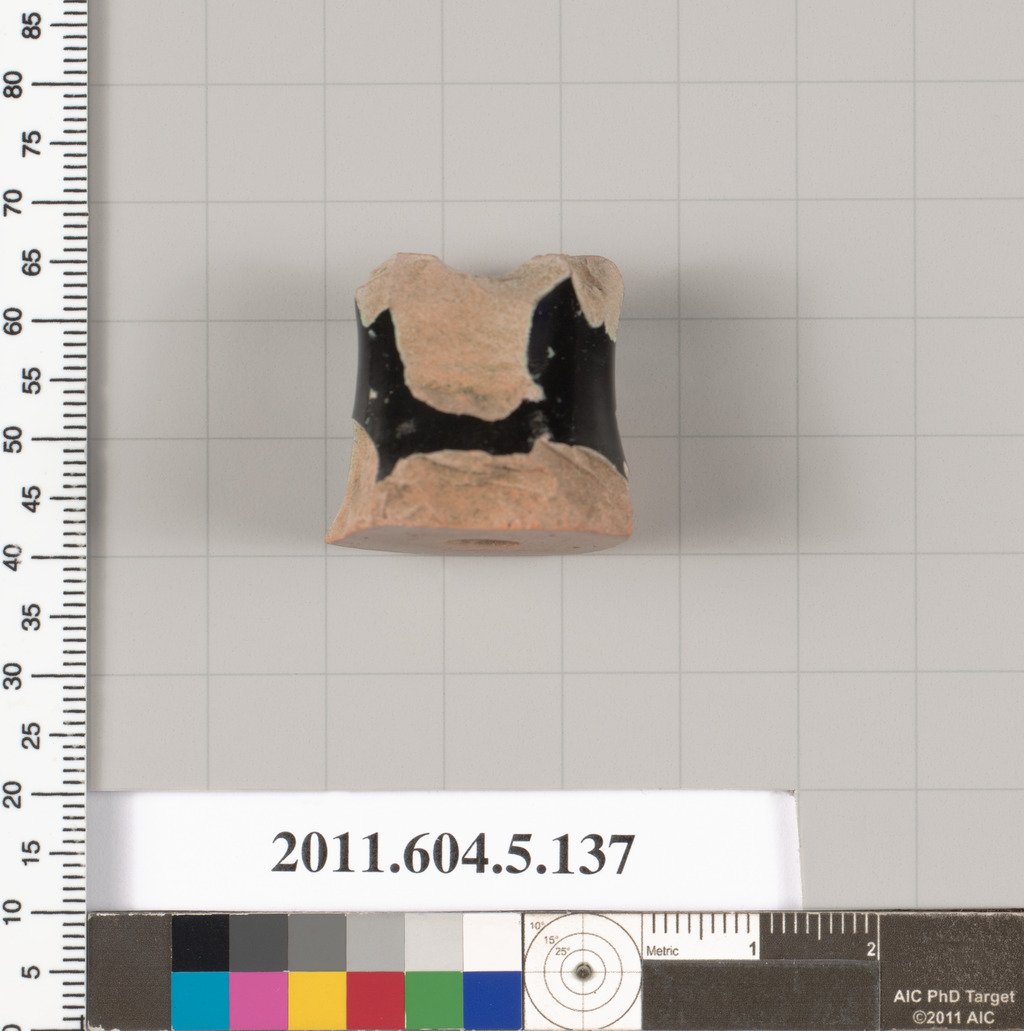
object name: kylix fragment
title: Terracotta fragment of a kylix (drinking cup)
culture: greek, attic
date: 600-401 BCE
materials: terracotta